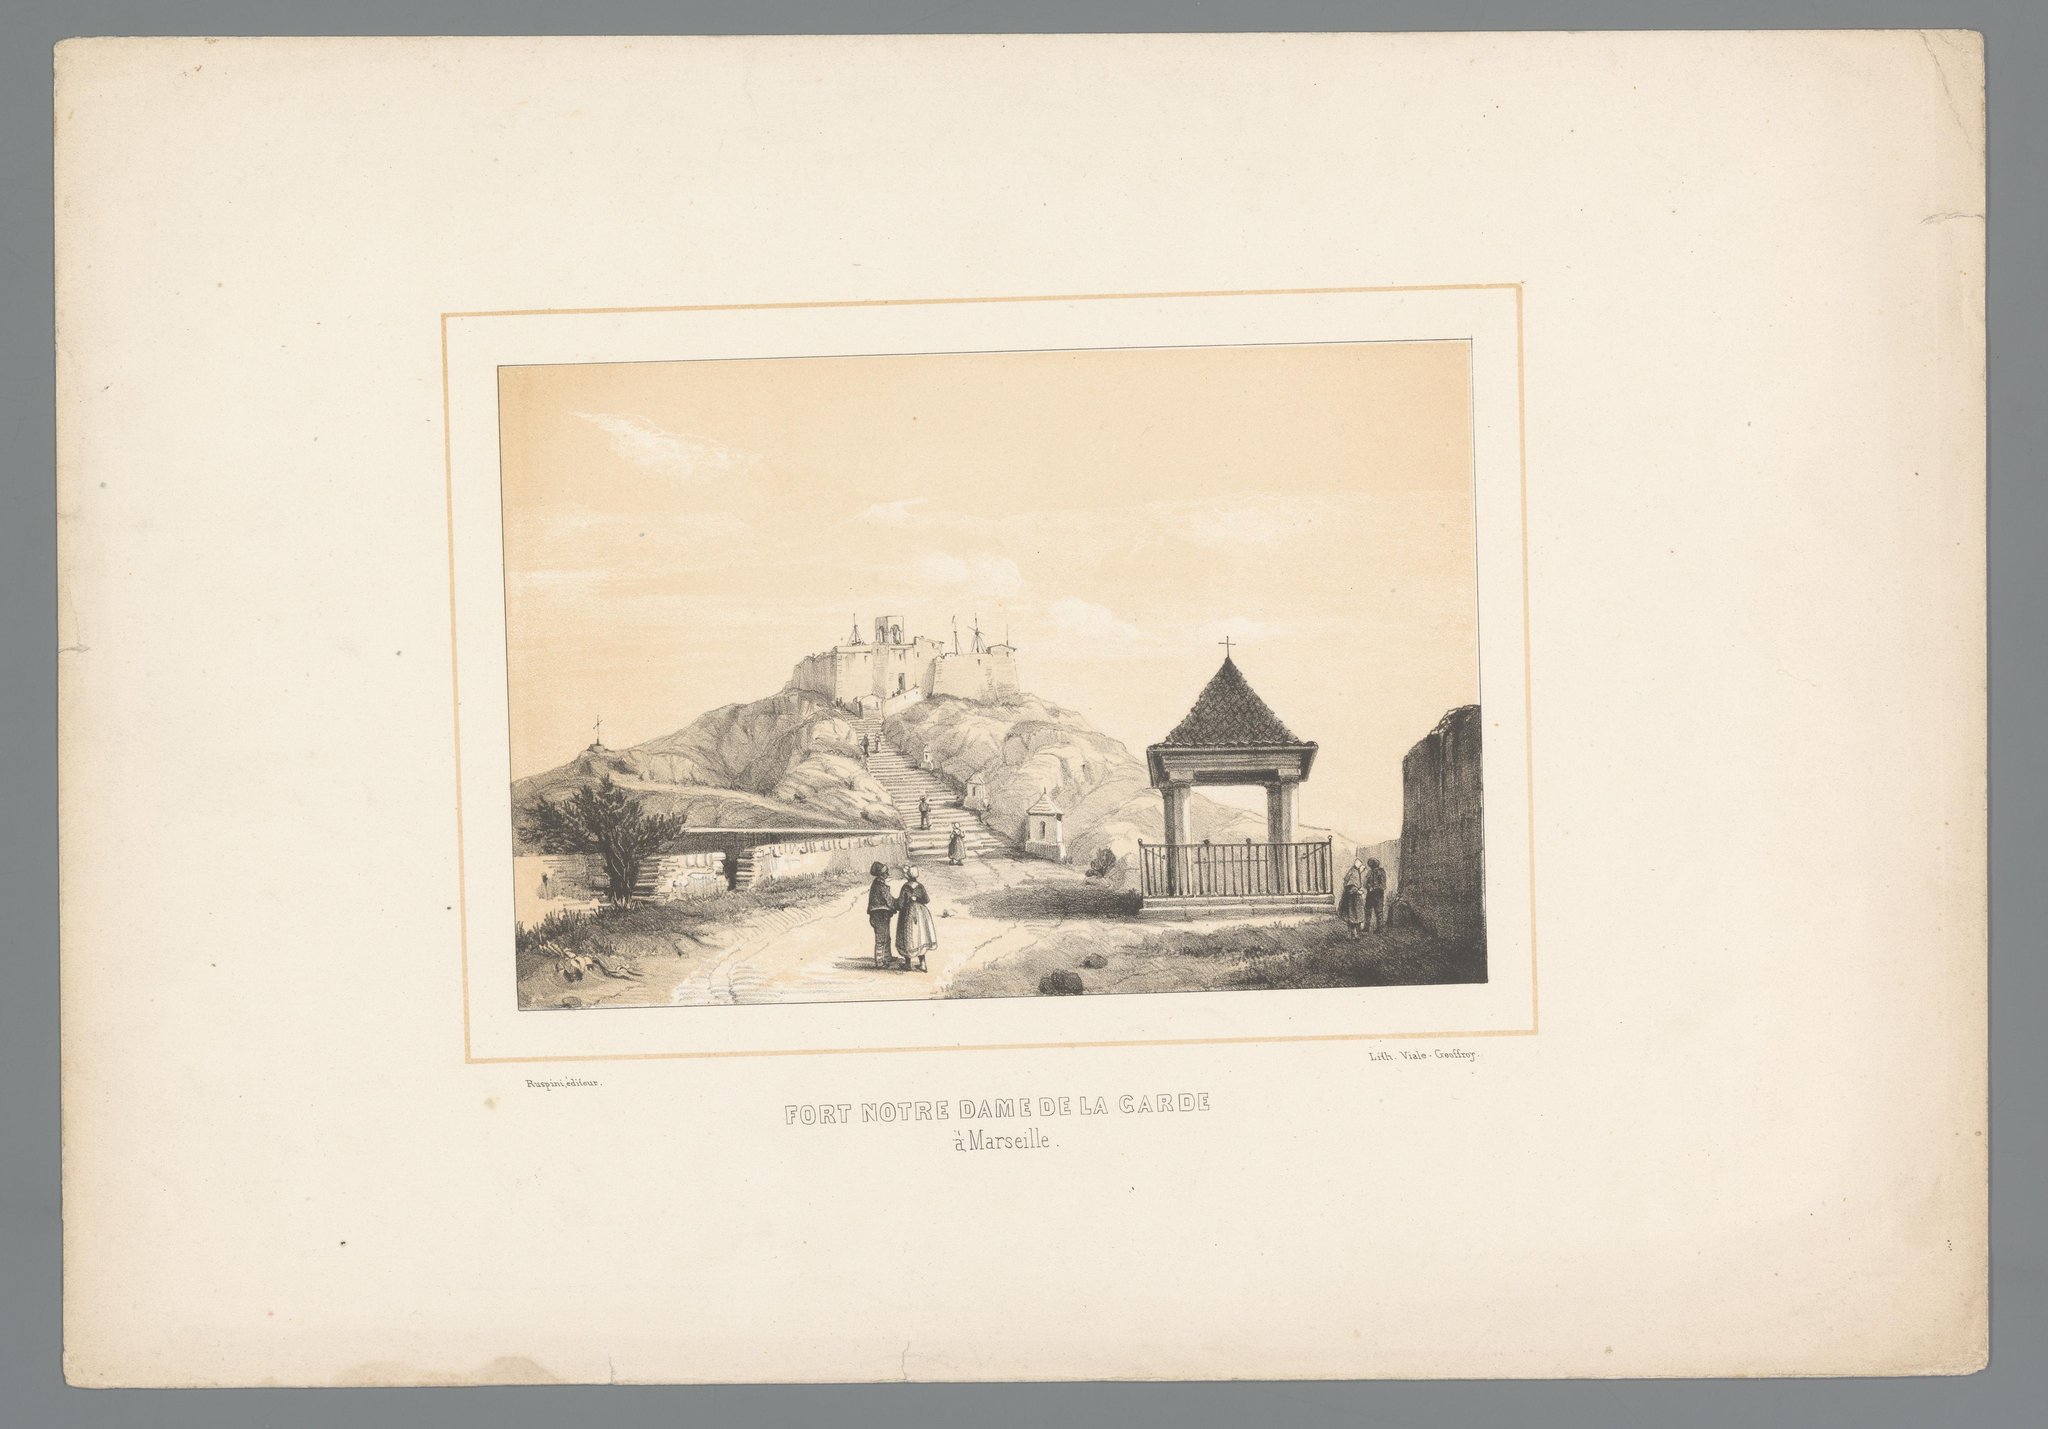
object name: print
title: Fort Notre-Dame de la Garde in Marseille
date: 1842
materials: paper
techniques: tone lithography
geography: marseille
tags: fortress, tourism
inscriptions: collector's mark: Lugt 2228